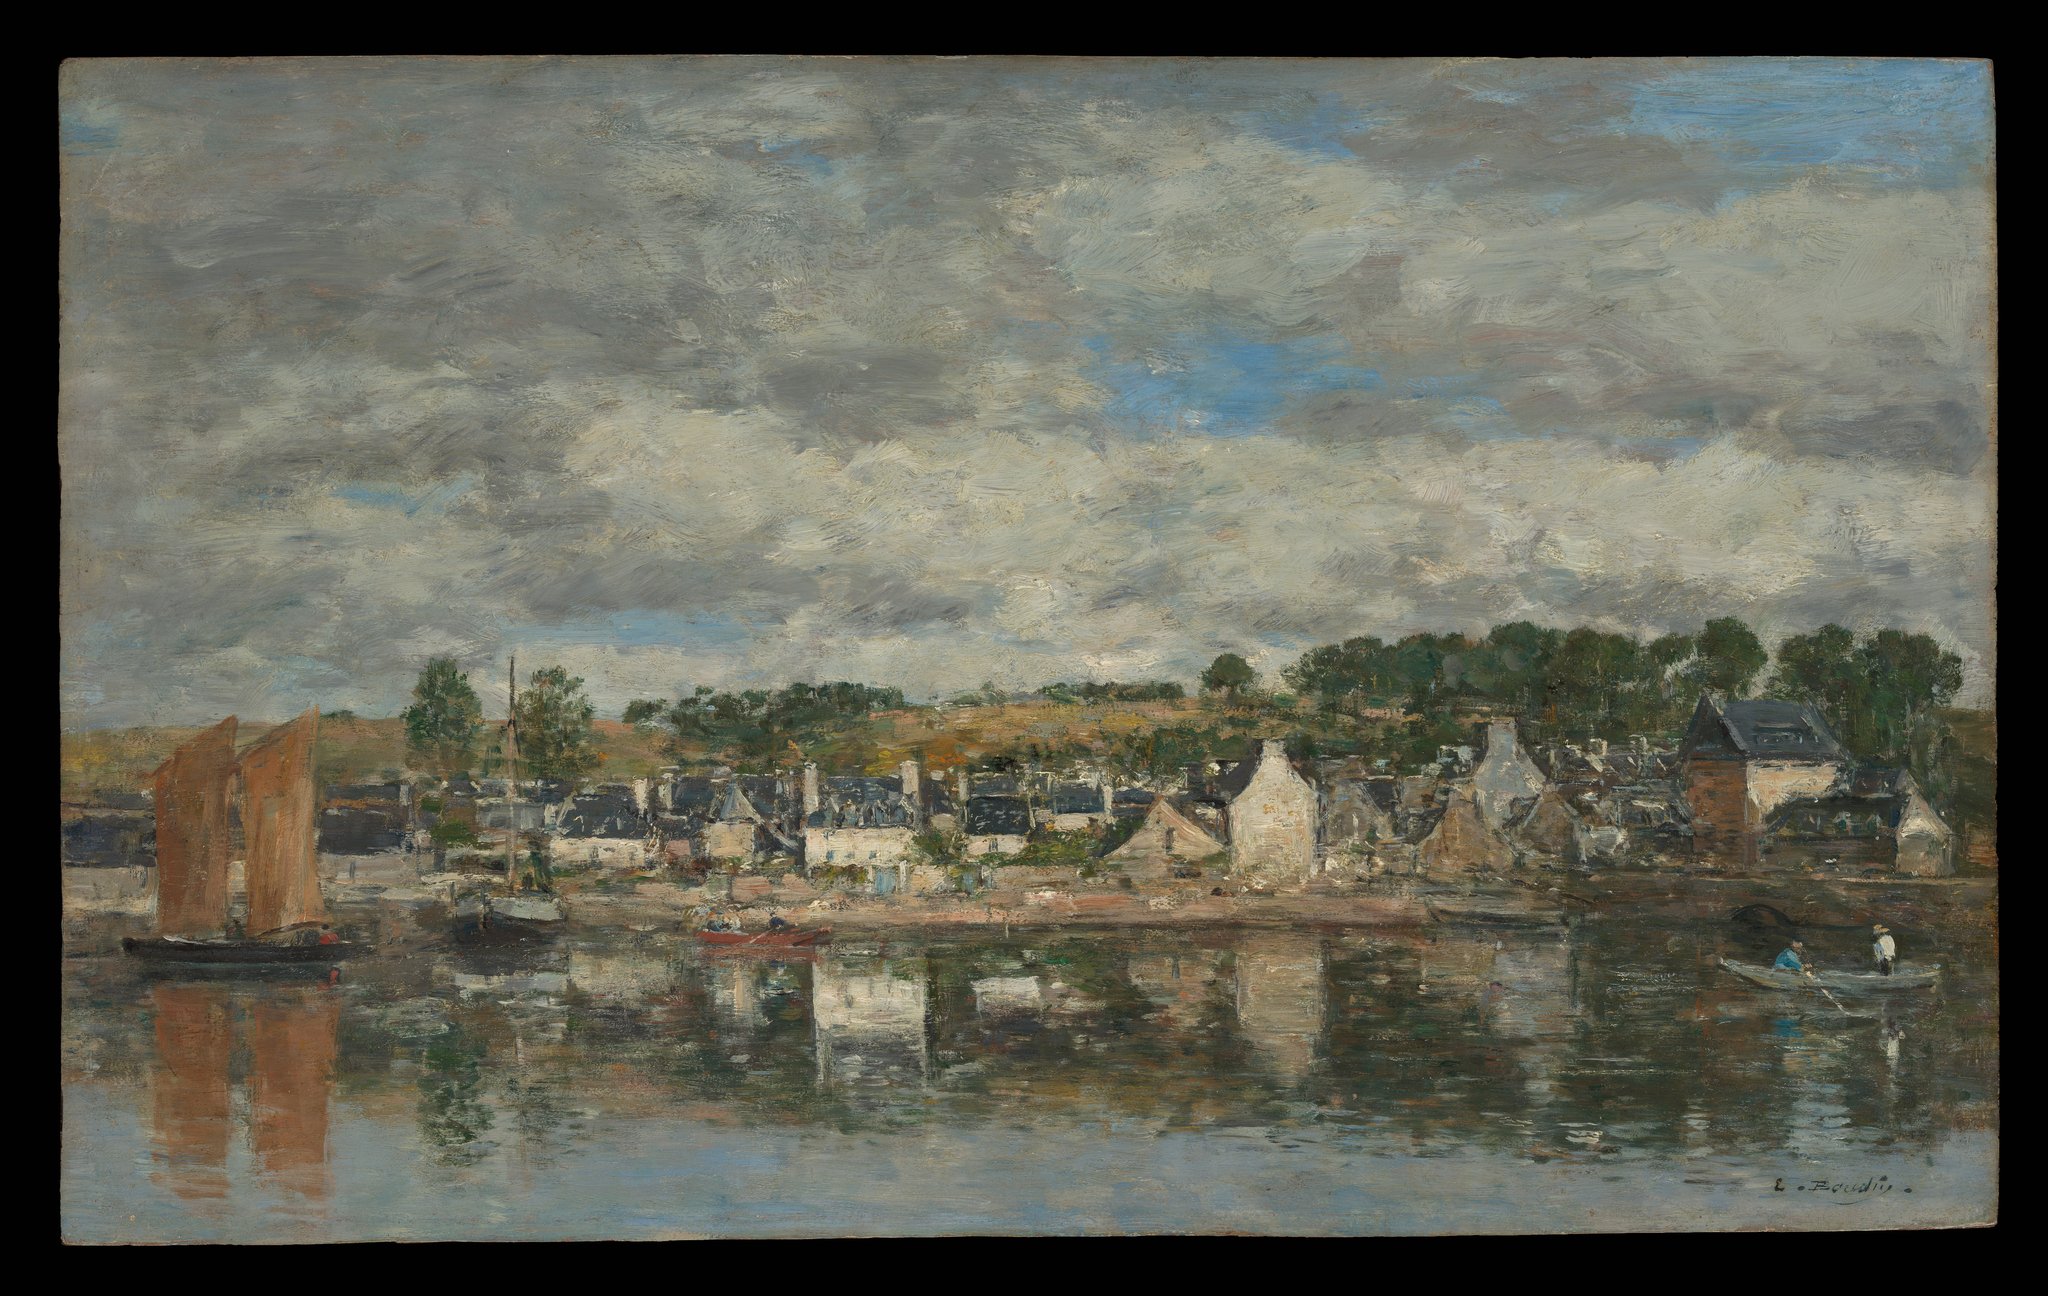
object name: painting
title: Village by a River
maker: eugène boudin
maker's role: artist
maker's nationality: french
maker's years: 1824-1898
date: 1867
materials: oil, wood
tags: villages,rivers,landscapes